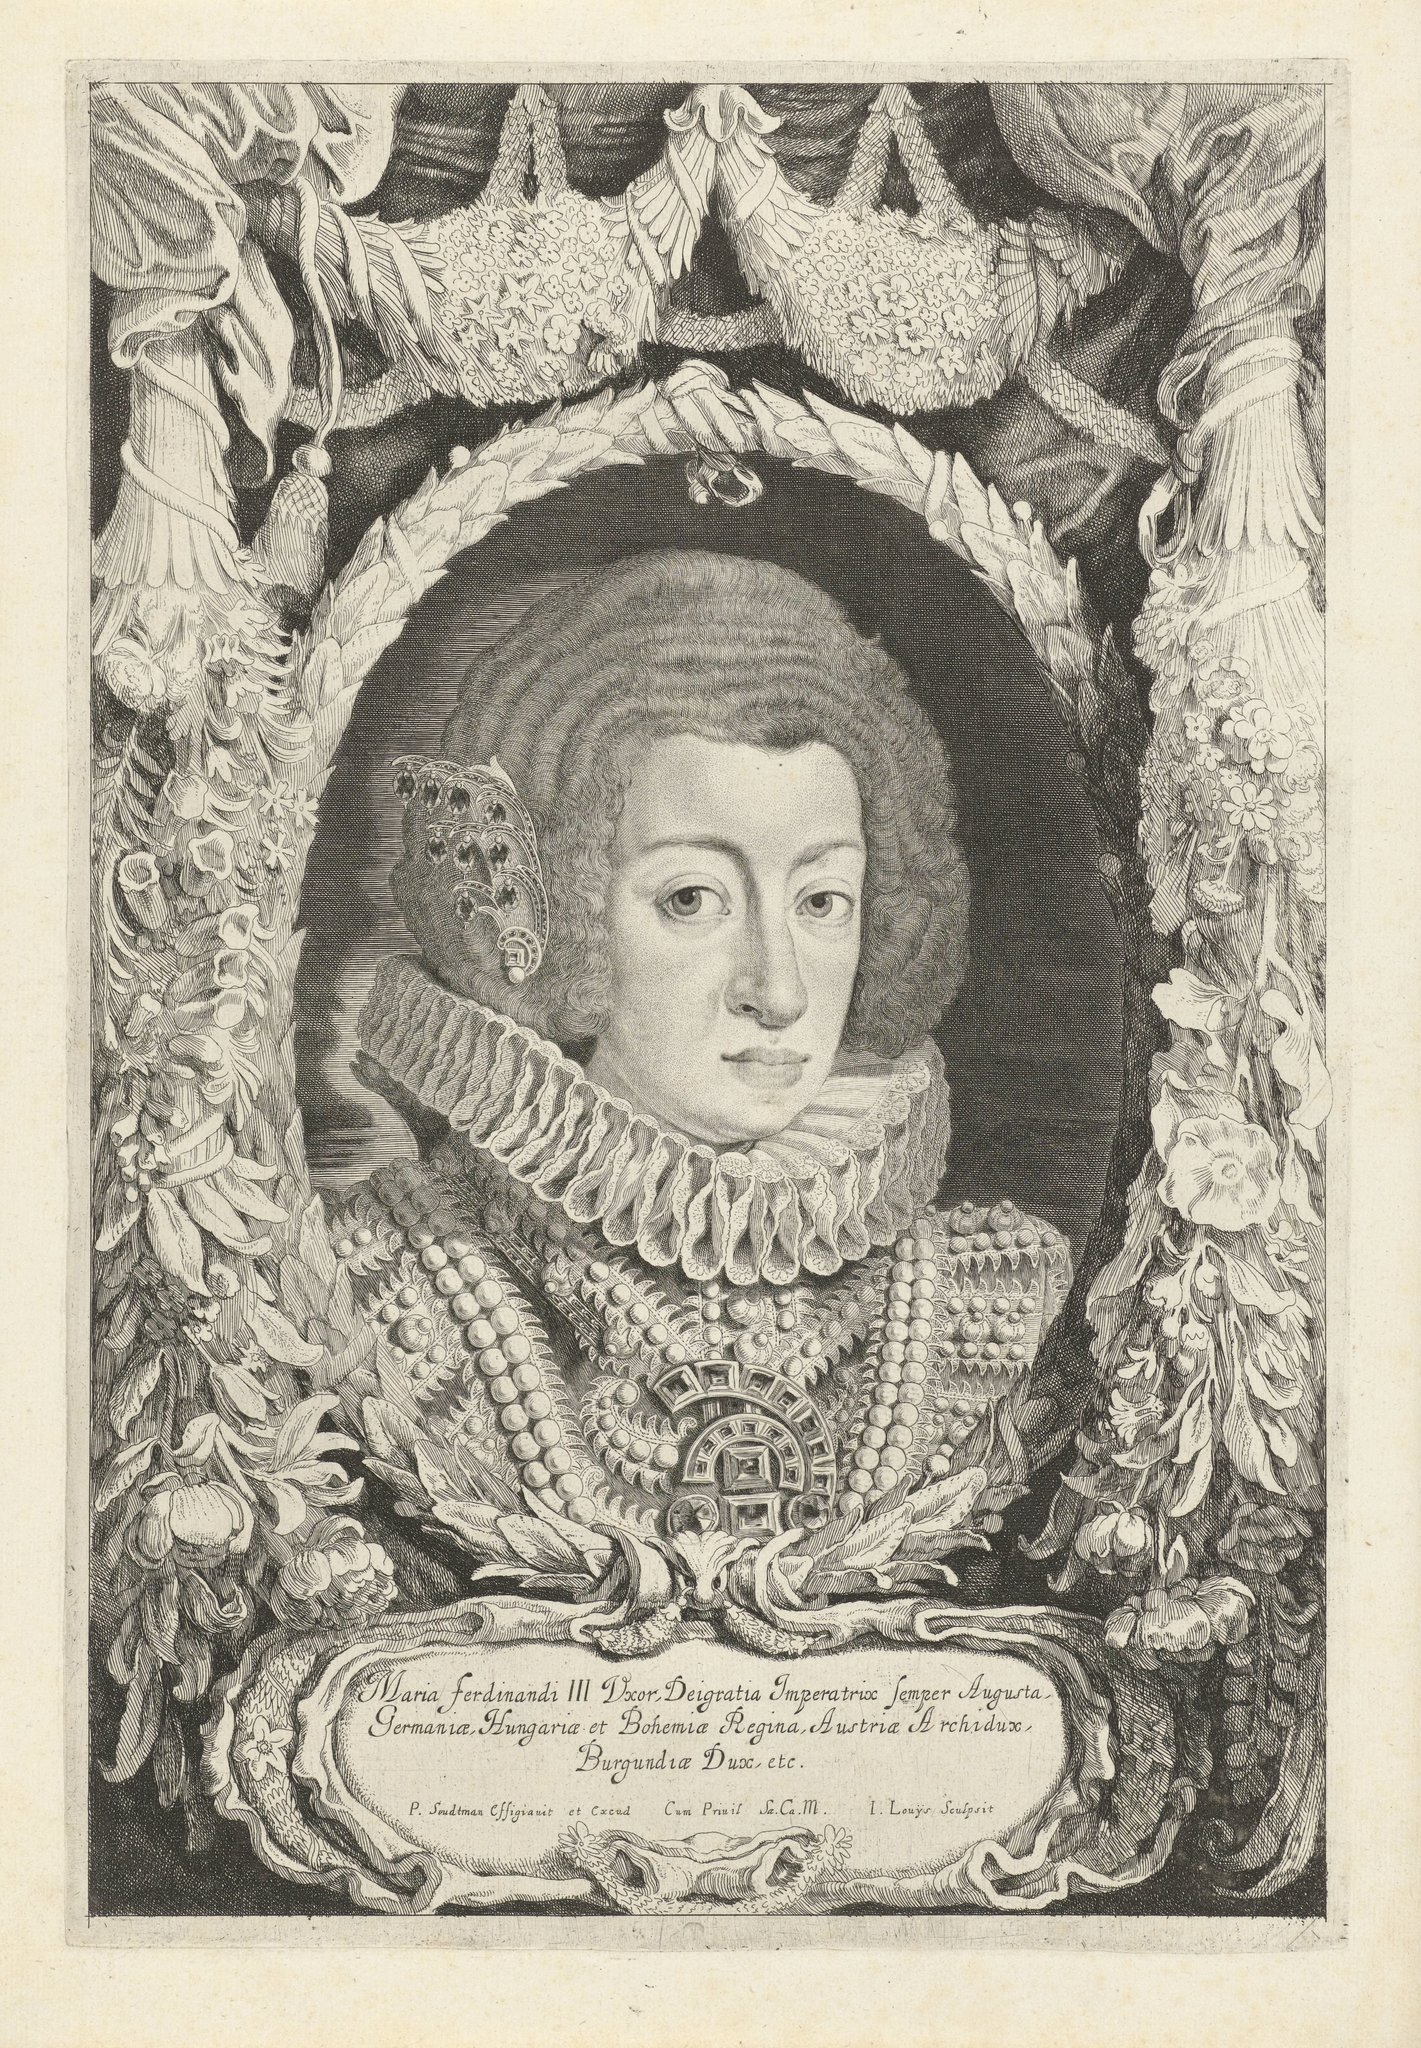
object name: print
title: Portret van Maria Anna van Spanje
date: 1644-1650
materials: paper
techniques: engraving, etching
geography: haarlem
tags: madrid, linz, keizerin, maria anna van oostenrijk (duits keizerin)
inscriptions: collector's mark: Lugt 2760, collector's mark: Lugt 2228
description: De prenten in de serie Ferdinandus II[us] et III[us] Imperatorum Domus Austriacae zijn vervaardigd door verschillende graveurs: Jonas Suyderhoef, Jacob Louys en Pieter van Sompel.